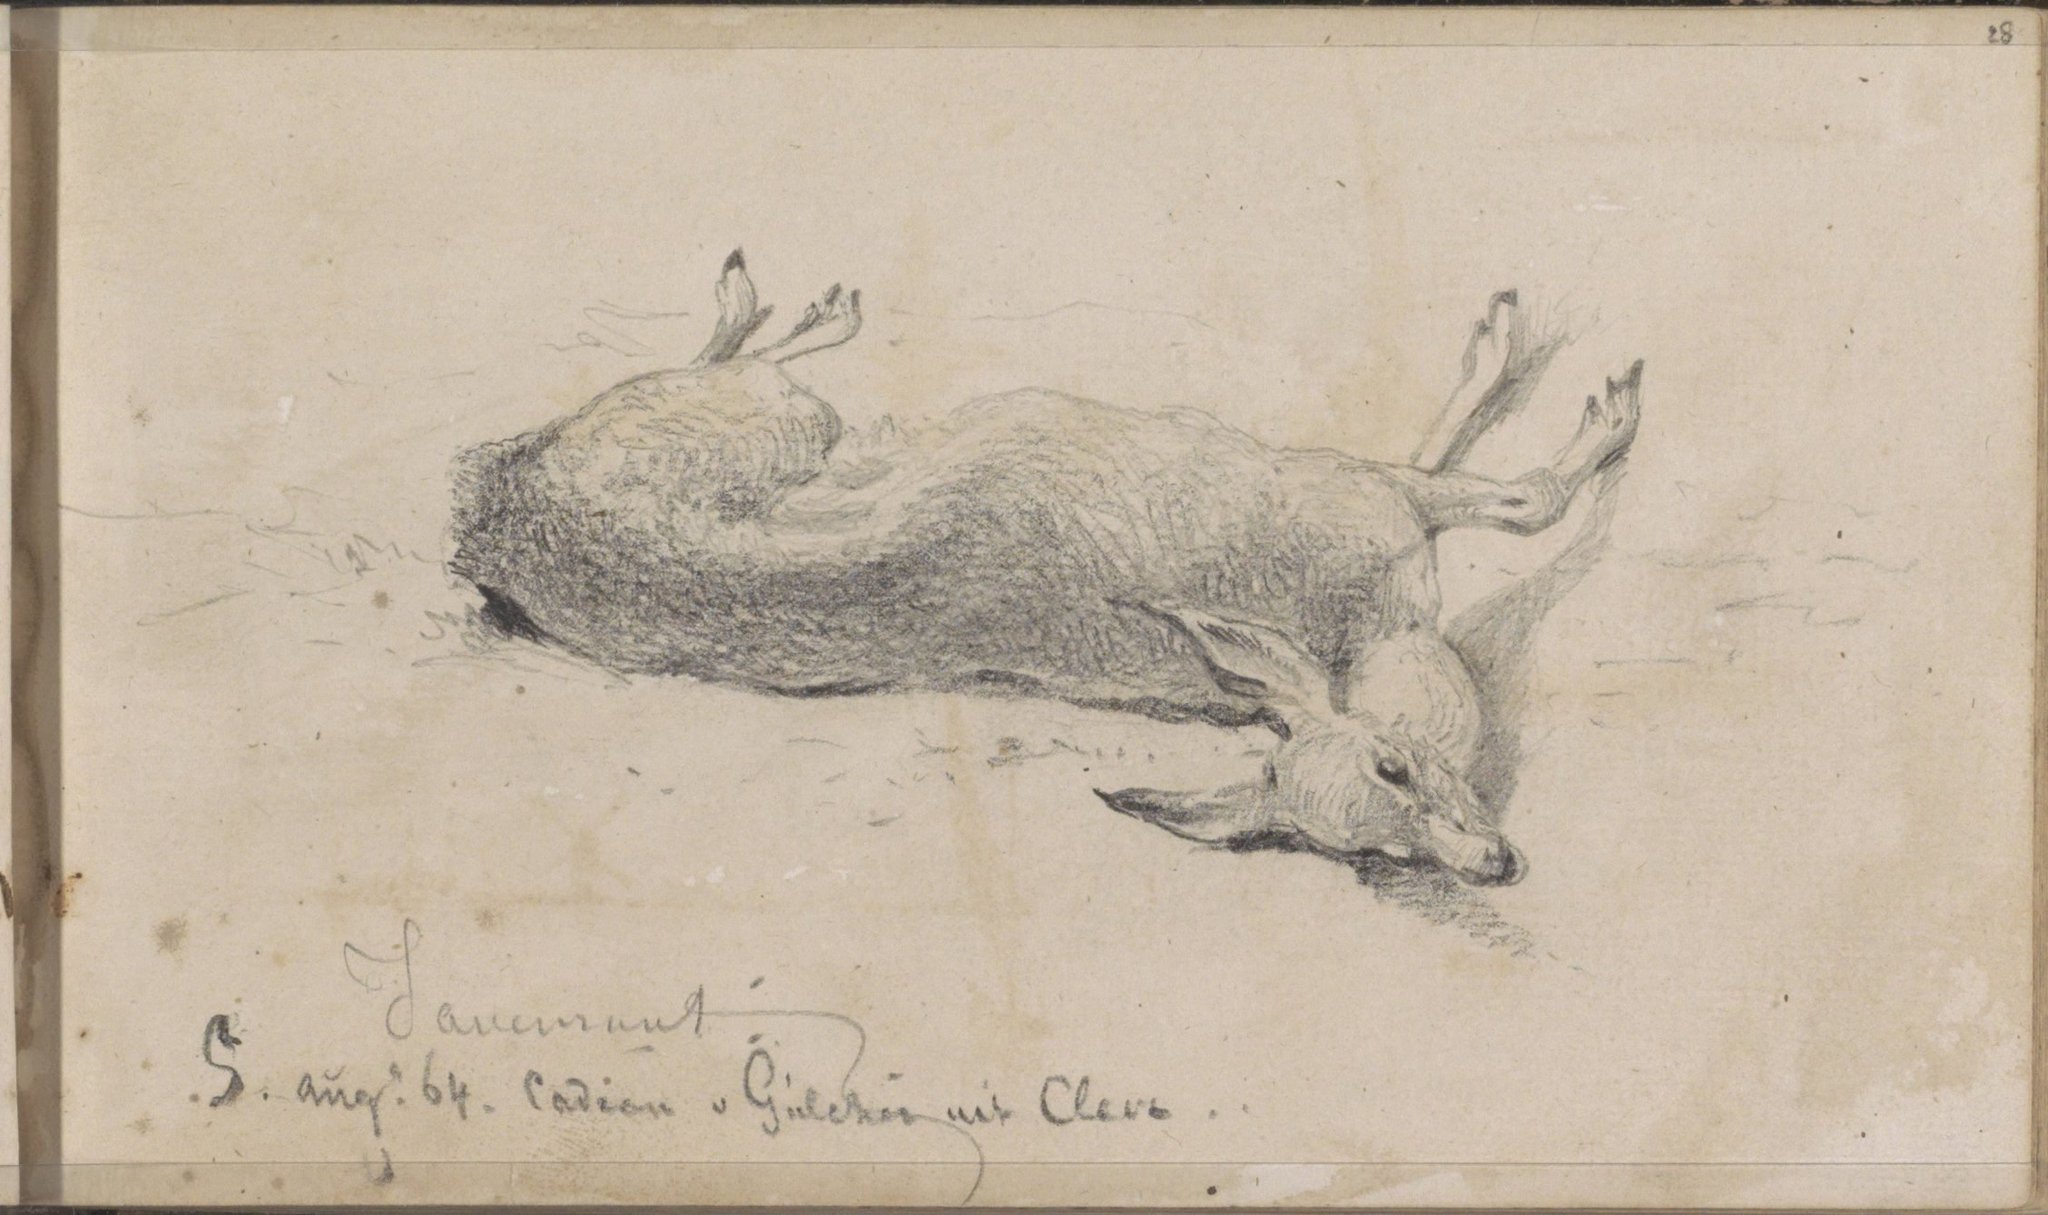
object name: sketchbook leaf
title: Dood hert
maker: johannes tavenraat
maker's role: draughtsman, painter, print maker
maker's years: 1809-1881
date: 1808-1864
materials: ink, paper, pencil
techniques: brush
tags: hoofed animals: deer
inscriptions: signature: ‘Tavenraat’, date and inscription: ‘5. aug.64. ca[...] v Gul[...]ker uit Cleve.’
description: Blad 28 recto uit een schetsboek met 98 bladen.